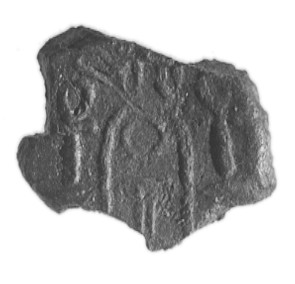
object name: sealing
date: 2030-1640 BCE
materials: clay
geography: egypt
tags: hieroglyphs